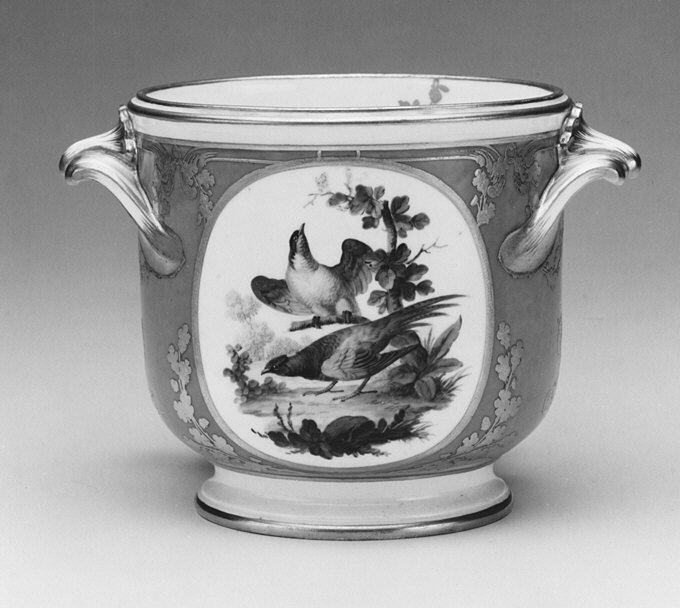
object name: wine cooler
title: Wine cooler (seau à demi-bouteille) (one of two) (part of a service)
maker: sèvres manufactory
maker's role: manufactory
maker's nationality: french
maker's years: 1740-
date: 1771-1772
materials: soft paste porcelain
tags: birds